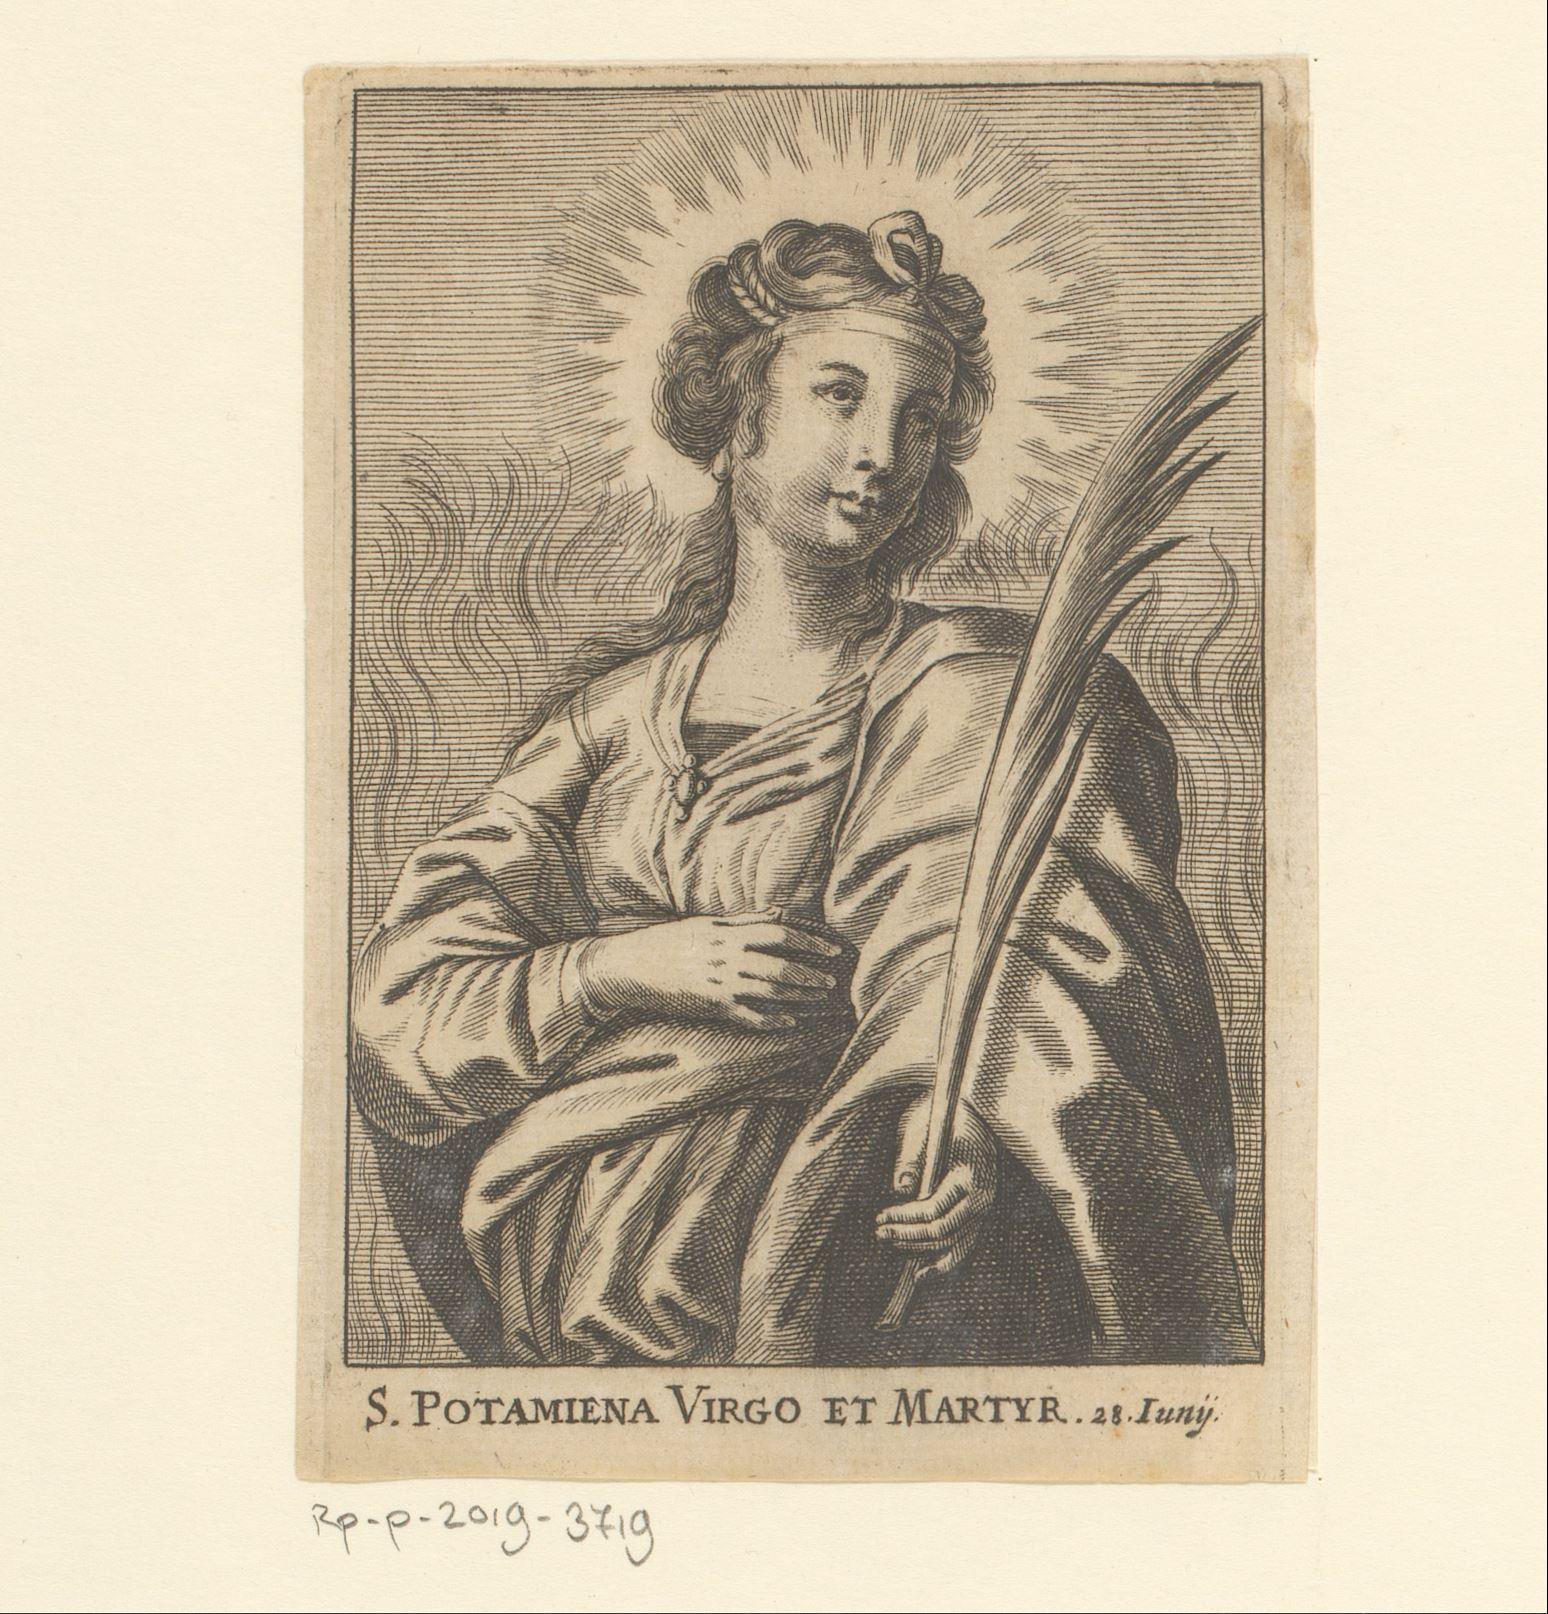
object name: print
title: S. Potamiena Virgo et Martyr. 28 Juny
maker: Anonymous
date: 1600-1699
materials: paper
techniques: engraving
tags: martyr(s) (often with palm-branches), female saints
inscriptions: collector's mark: Lugt 2228